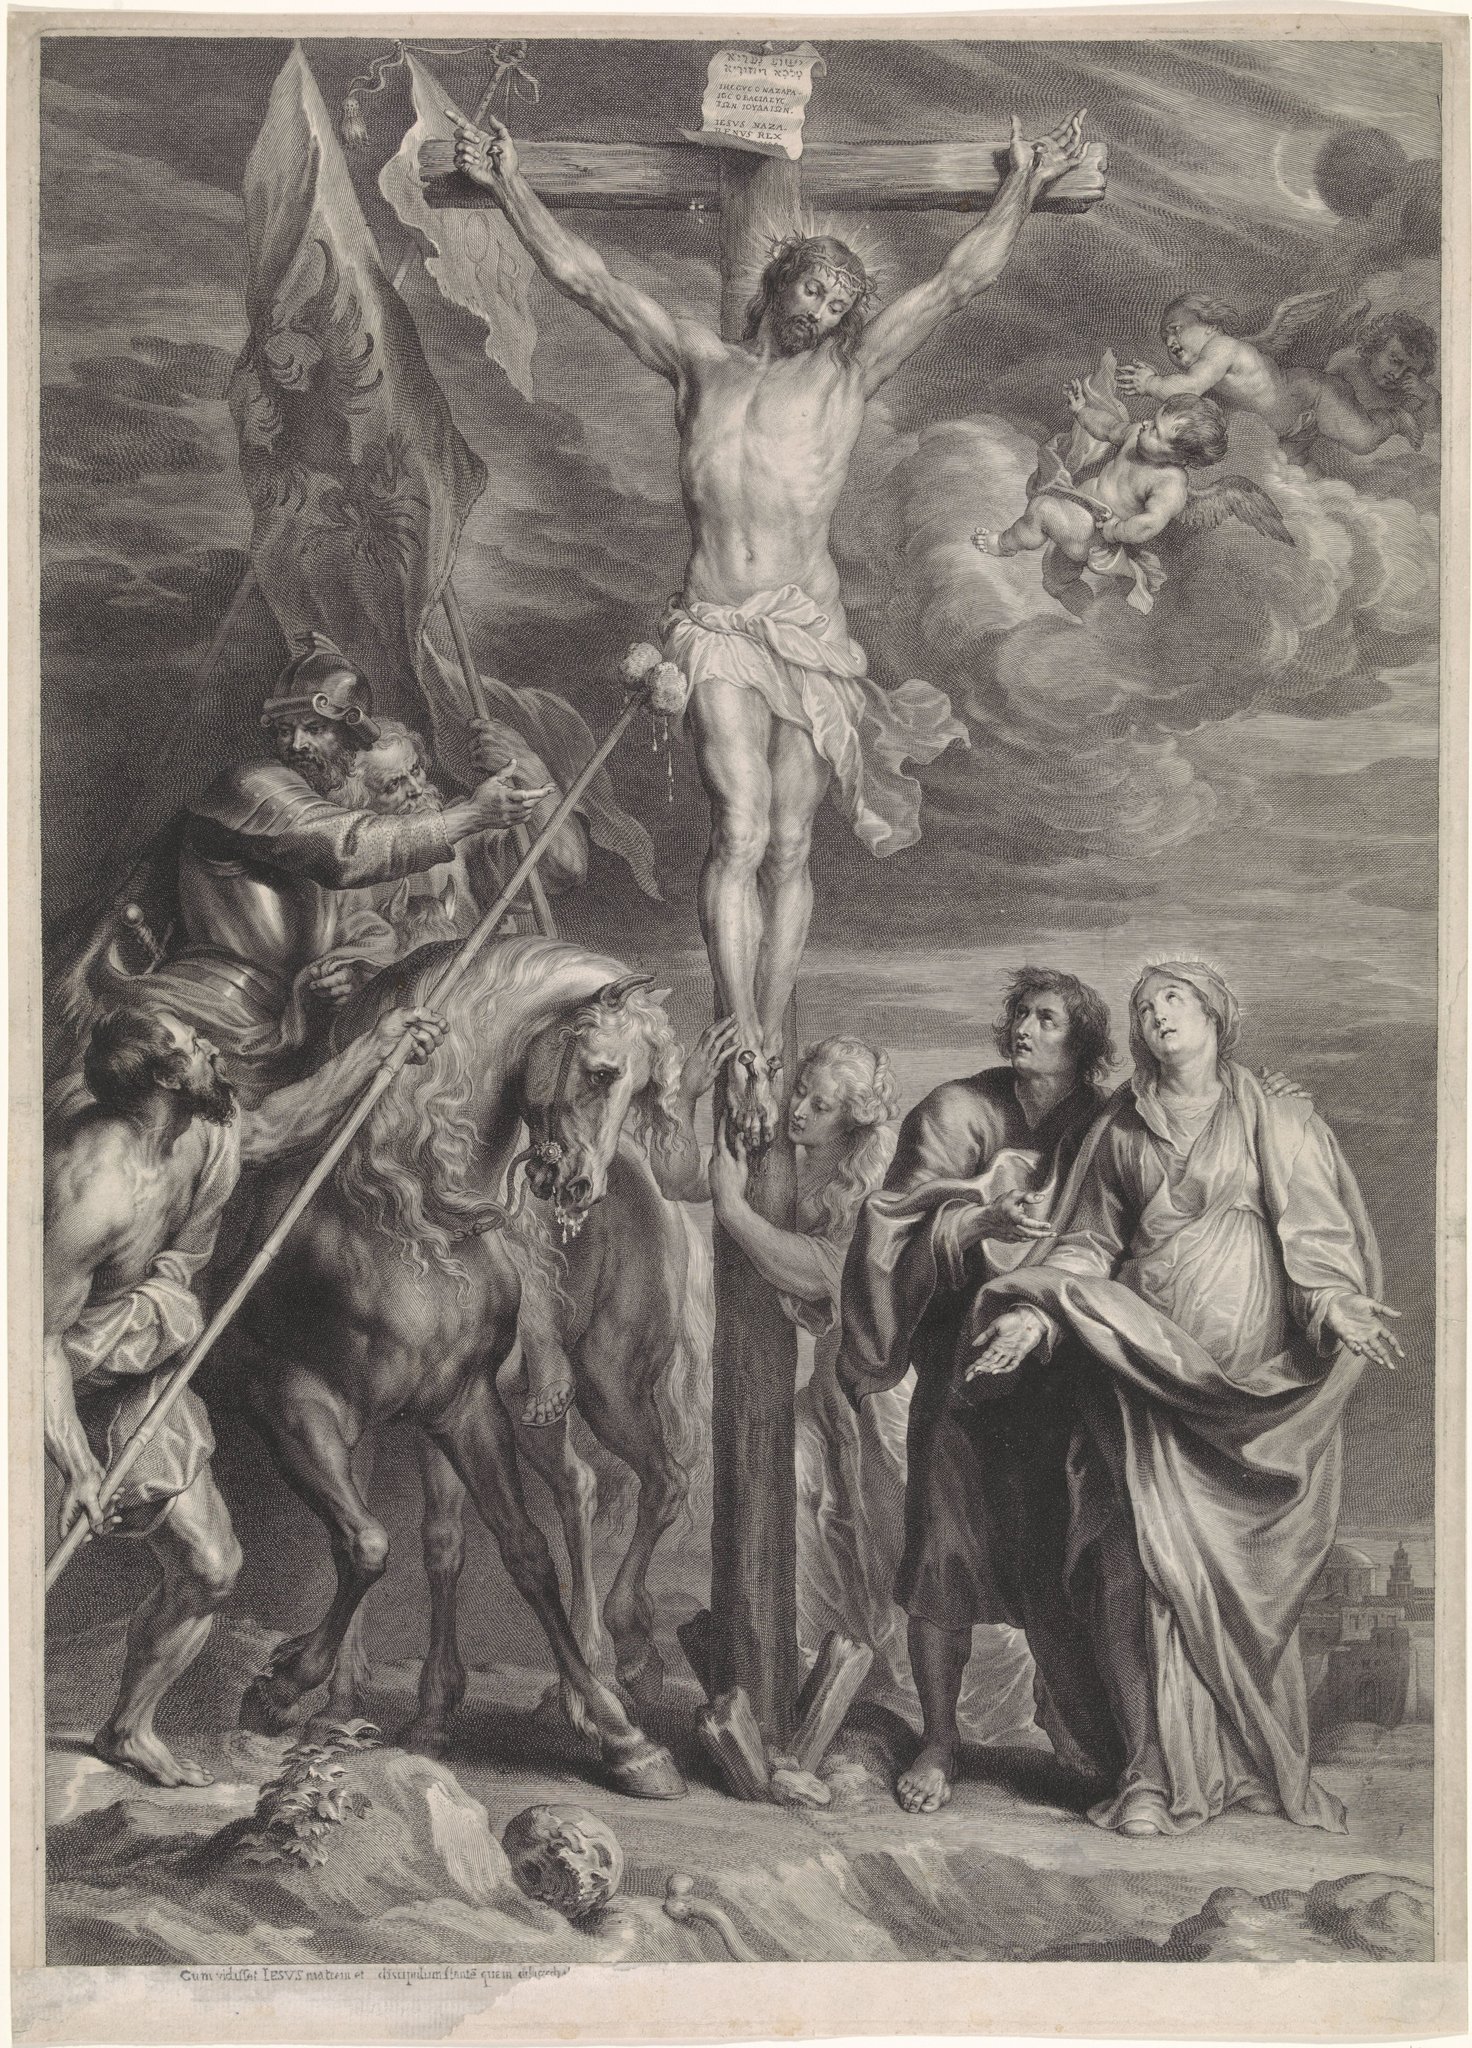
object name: print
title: Christus aan het kruis, met Maria, Johannes, Maria Magdalena en soldaten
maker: schelte adamsz. bolswert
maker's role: print maker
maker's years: 1586-1659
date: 1596-1659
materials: paper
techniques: engraving, pen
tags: crucified christ with mary, john, and mary magdalene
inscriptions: collector's mark: Lugt 240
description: Prent naar schilderij van Anthony van Dyck. Het blad is gerestaureerd waarbij een doublure is aangebracht en een deel van het opschrift van de prent in de vierde staat met pen in grijze inkt in de marge geschreven. De druk toont een opgewerkte versie van de vierde staat.